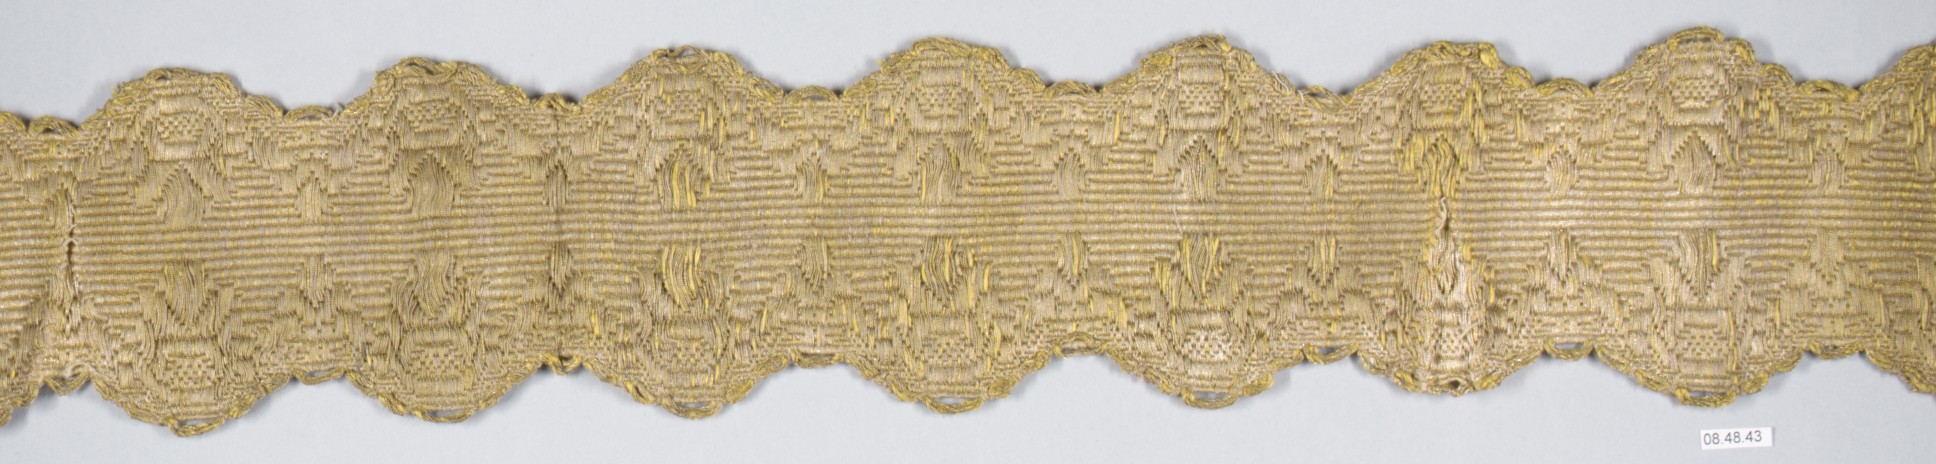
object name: galloon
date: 1701-1800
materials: silk